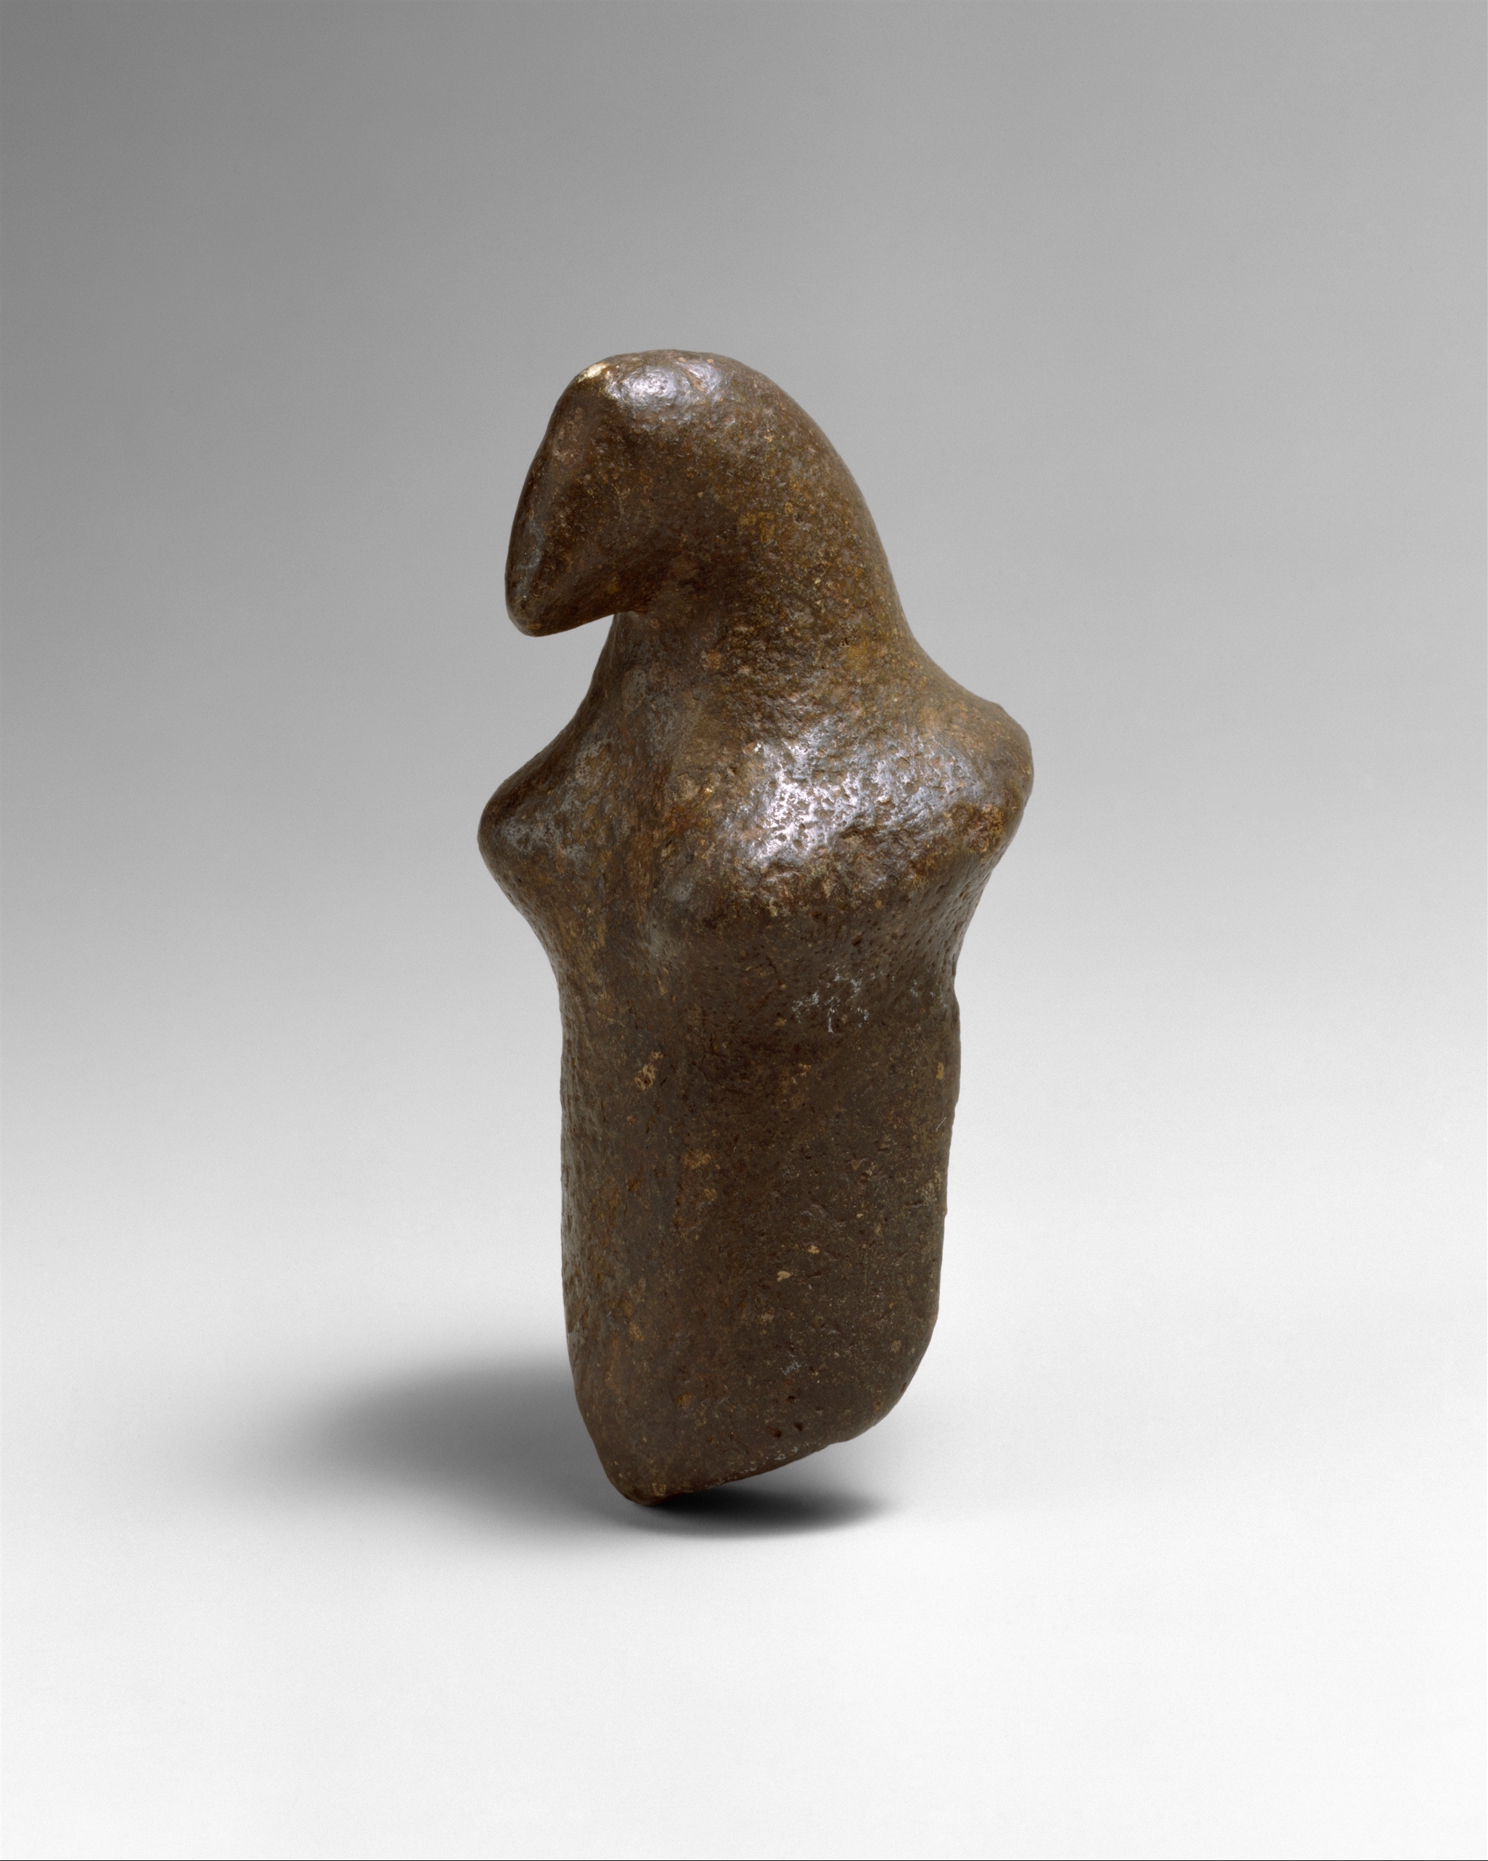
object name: pestle finial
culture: highlands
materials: stone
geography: papua new guinea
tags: birds